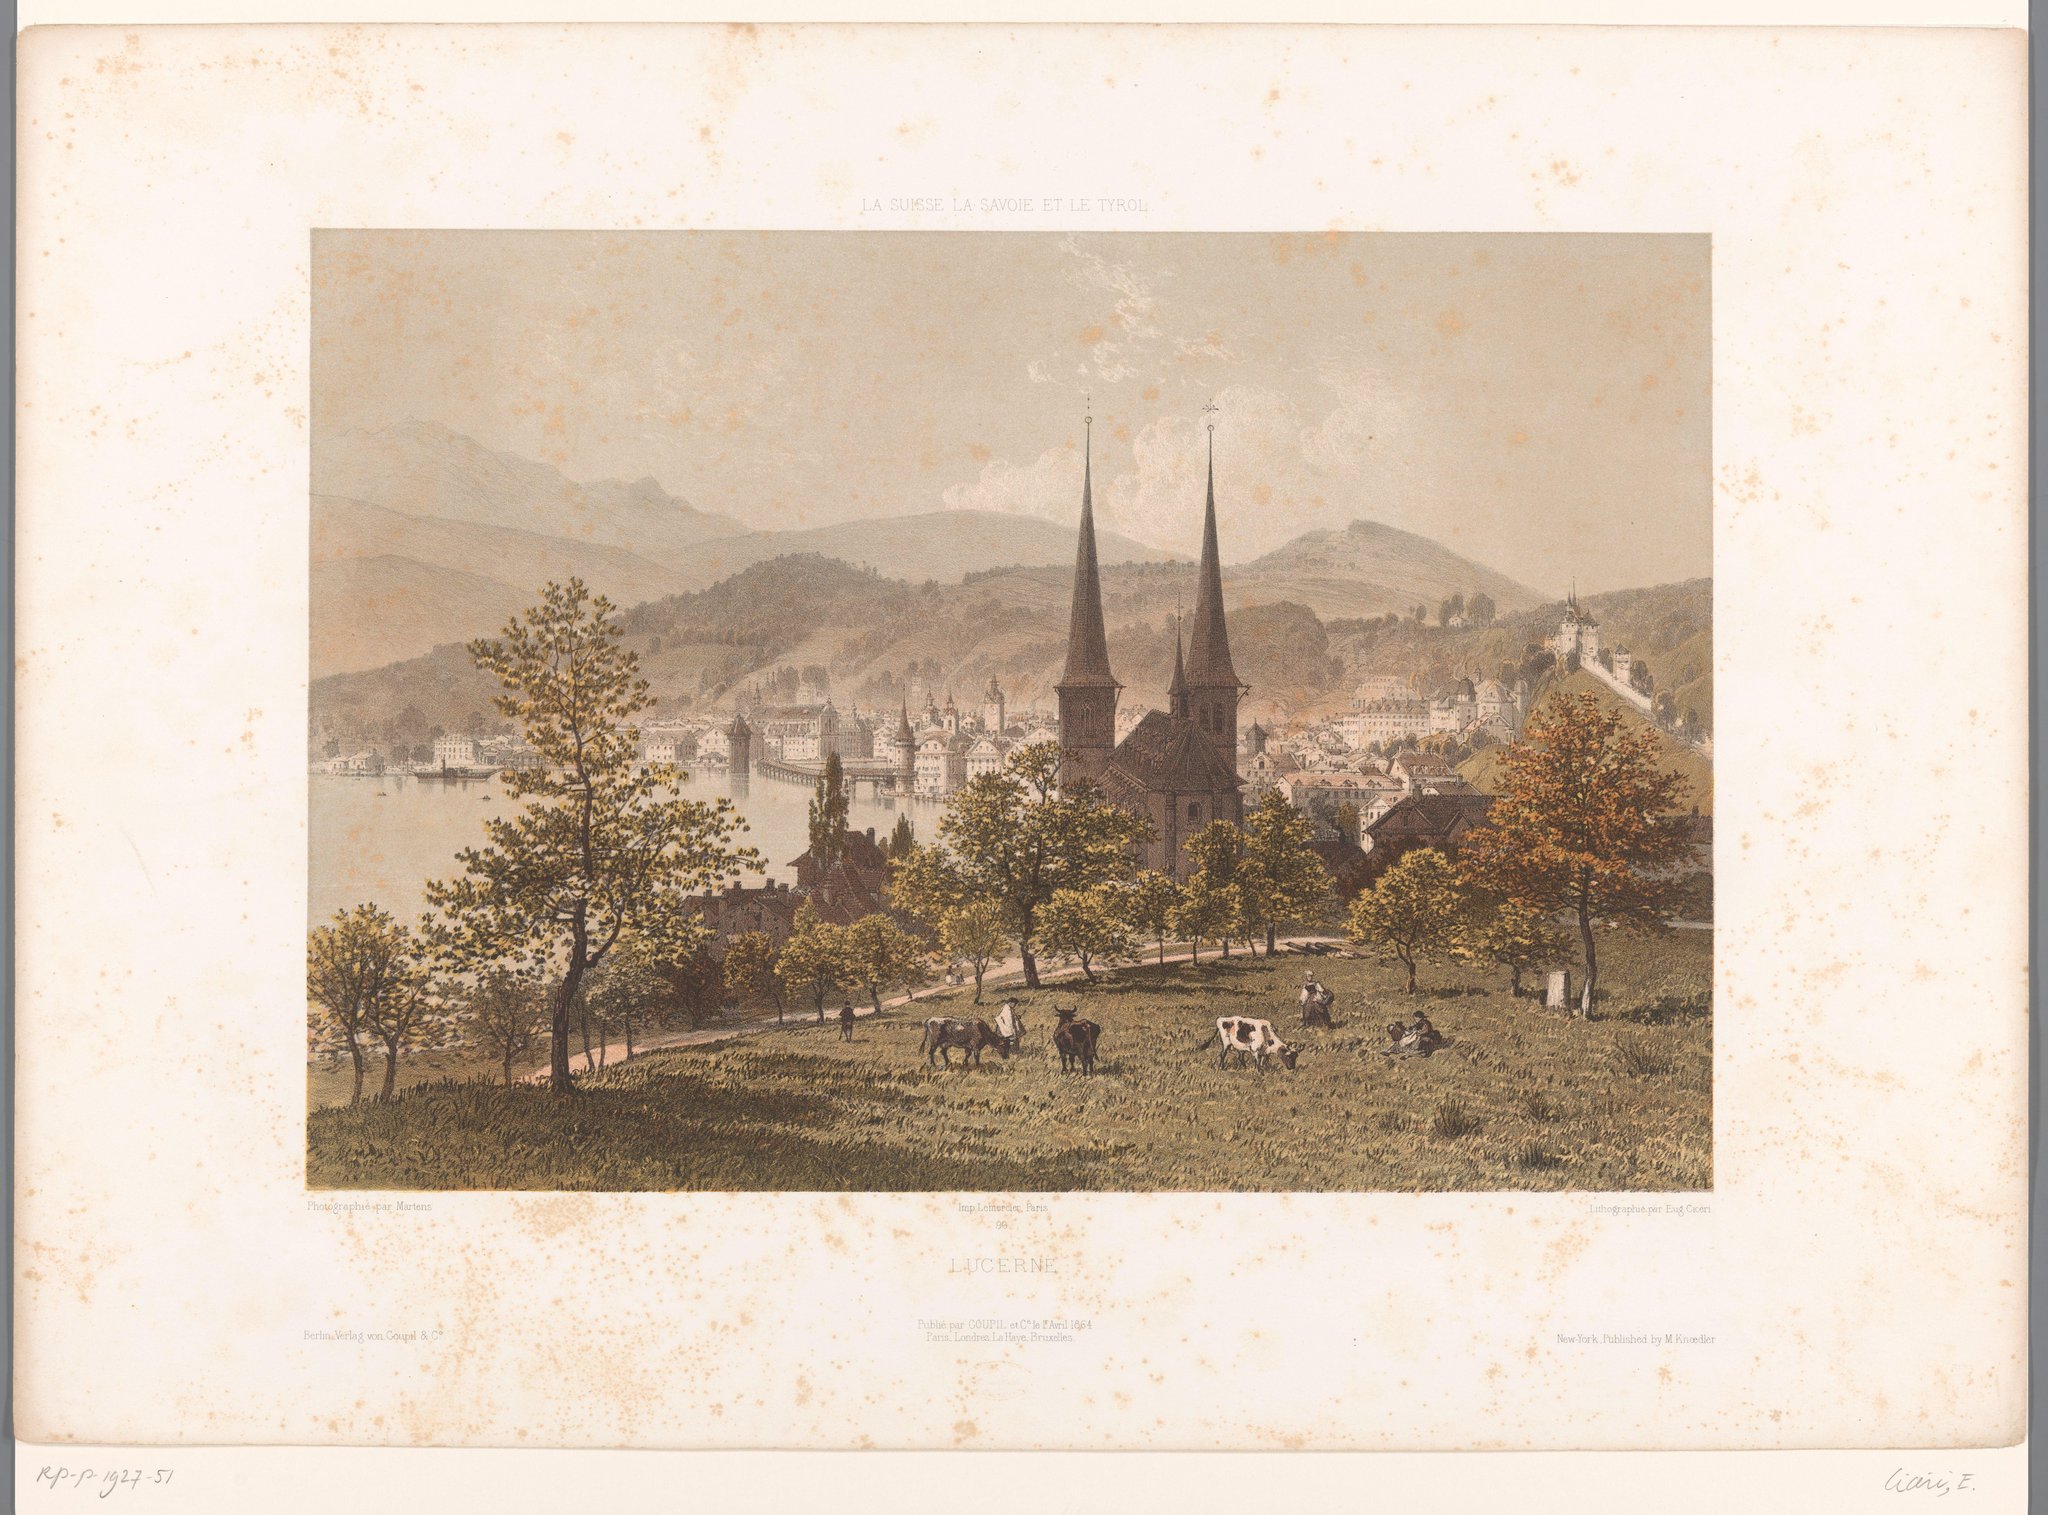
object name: print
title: Zicht op Luzern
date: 1859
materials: paper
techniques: lithograph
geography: new york city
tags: city-view in general; 'veduta', lake, mountains (+ landscape with figures, staffage)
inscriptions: check stamp: Lugt 1090